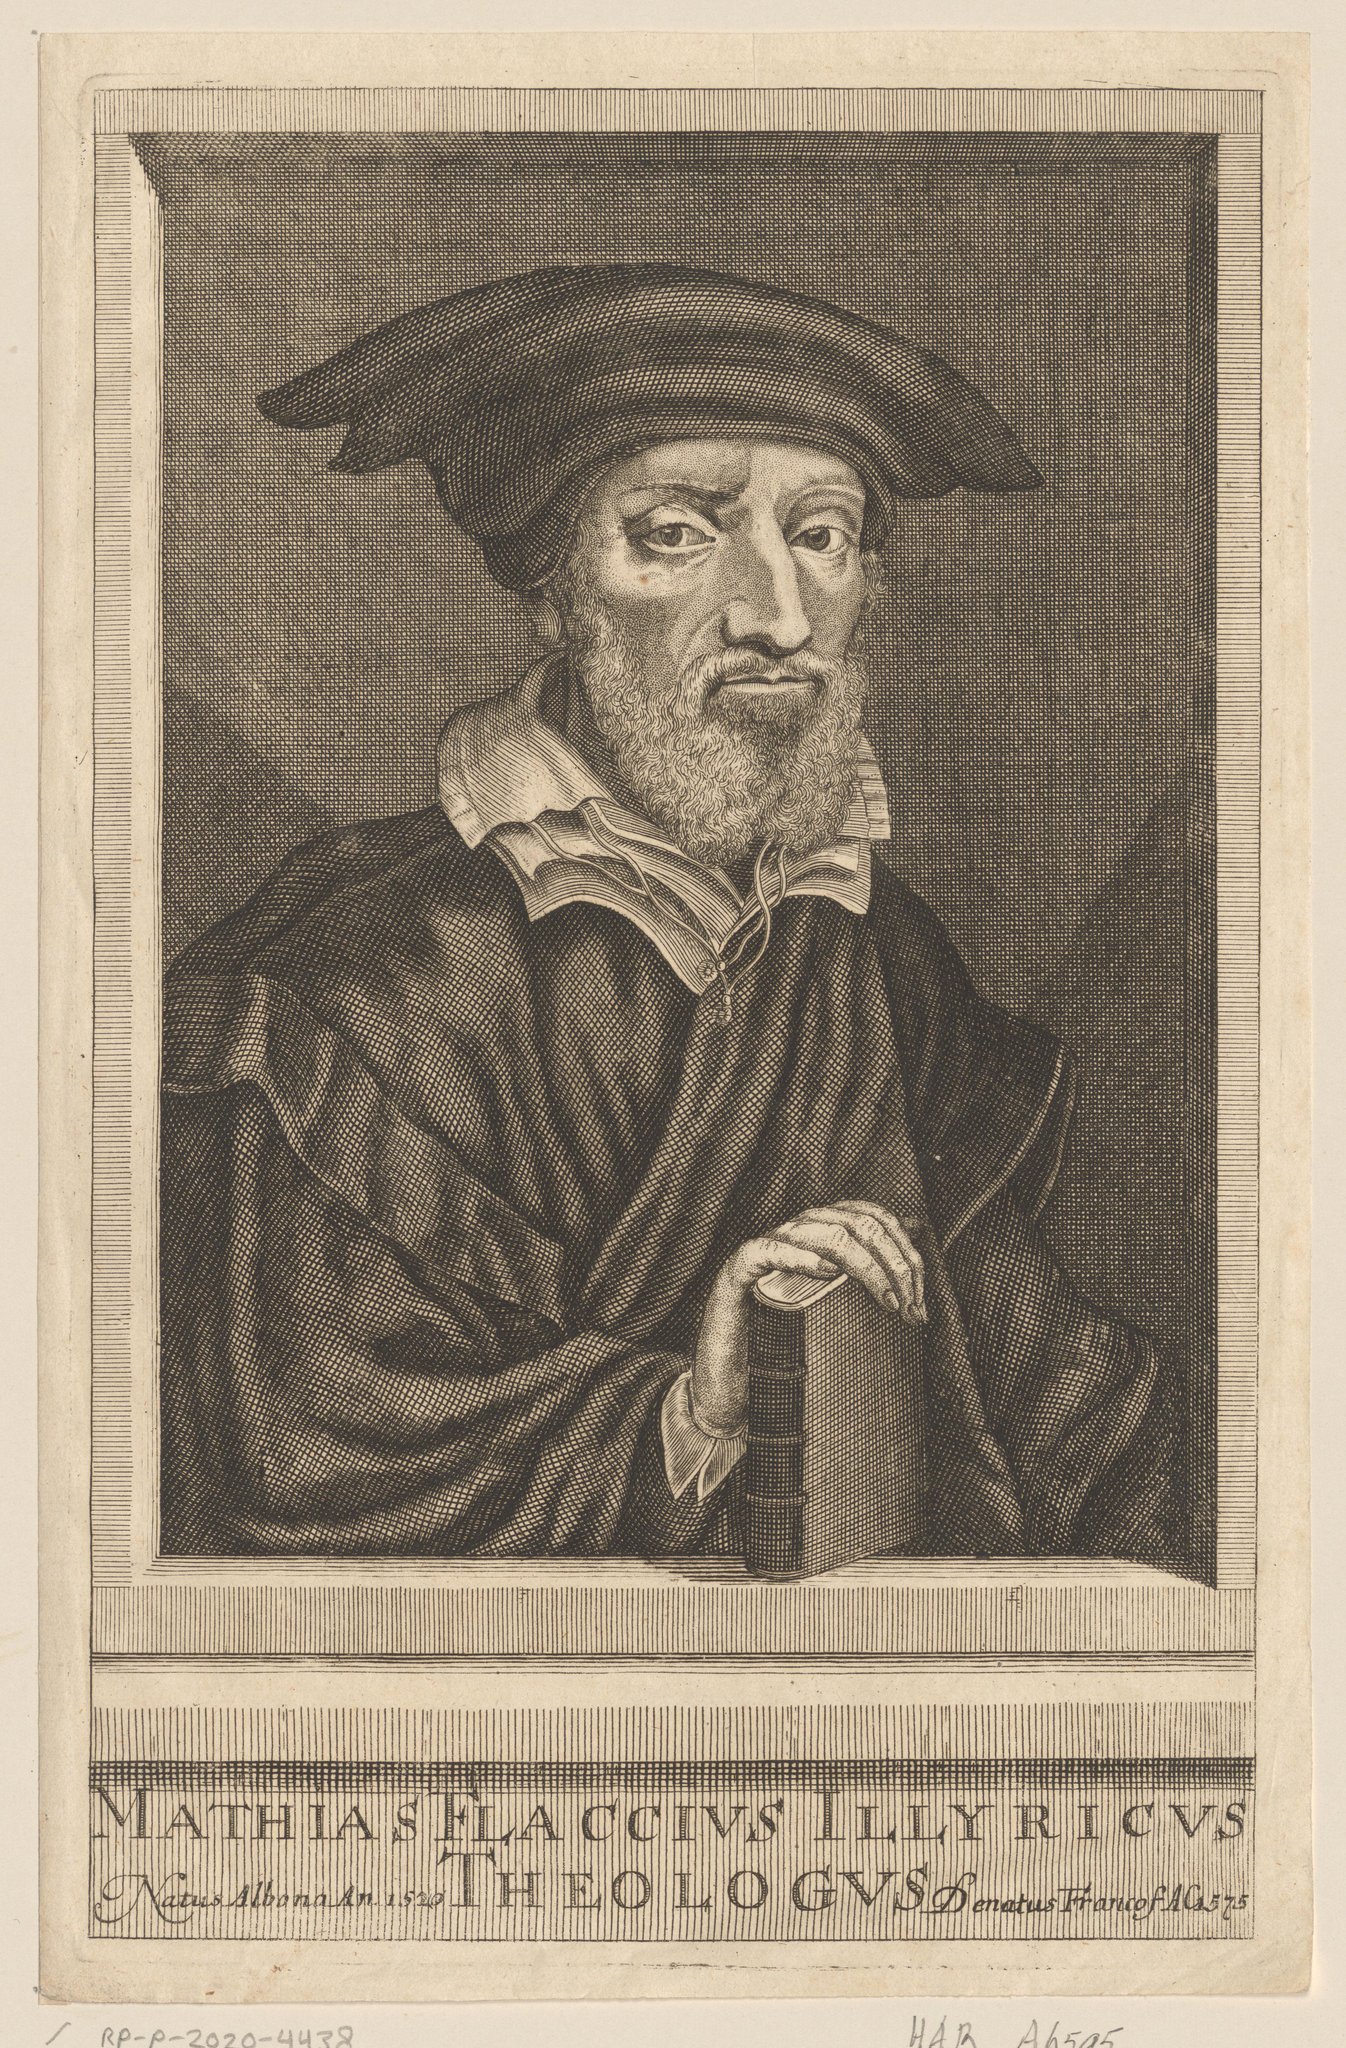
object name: print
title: Portret van Matthias Flacius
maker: nicolaus häublin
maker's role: print maker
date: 1650-1685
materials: paper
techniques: etching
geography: germany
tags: theologian, historical persons, book